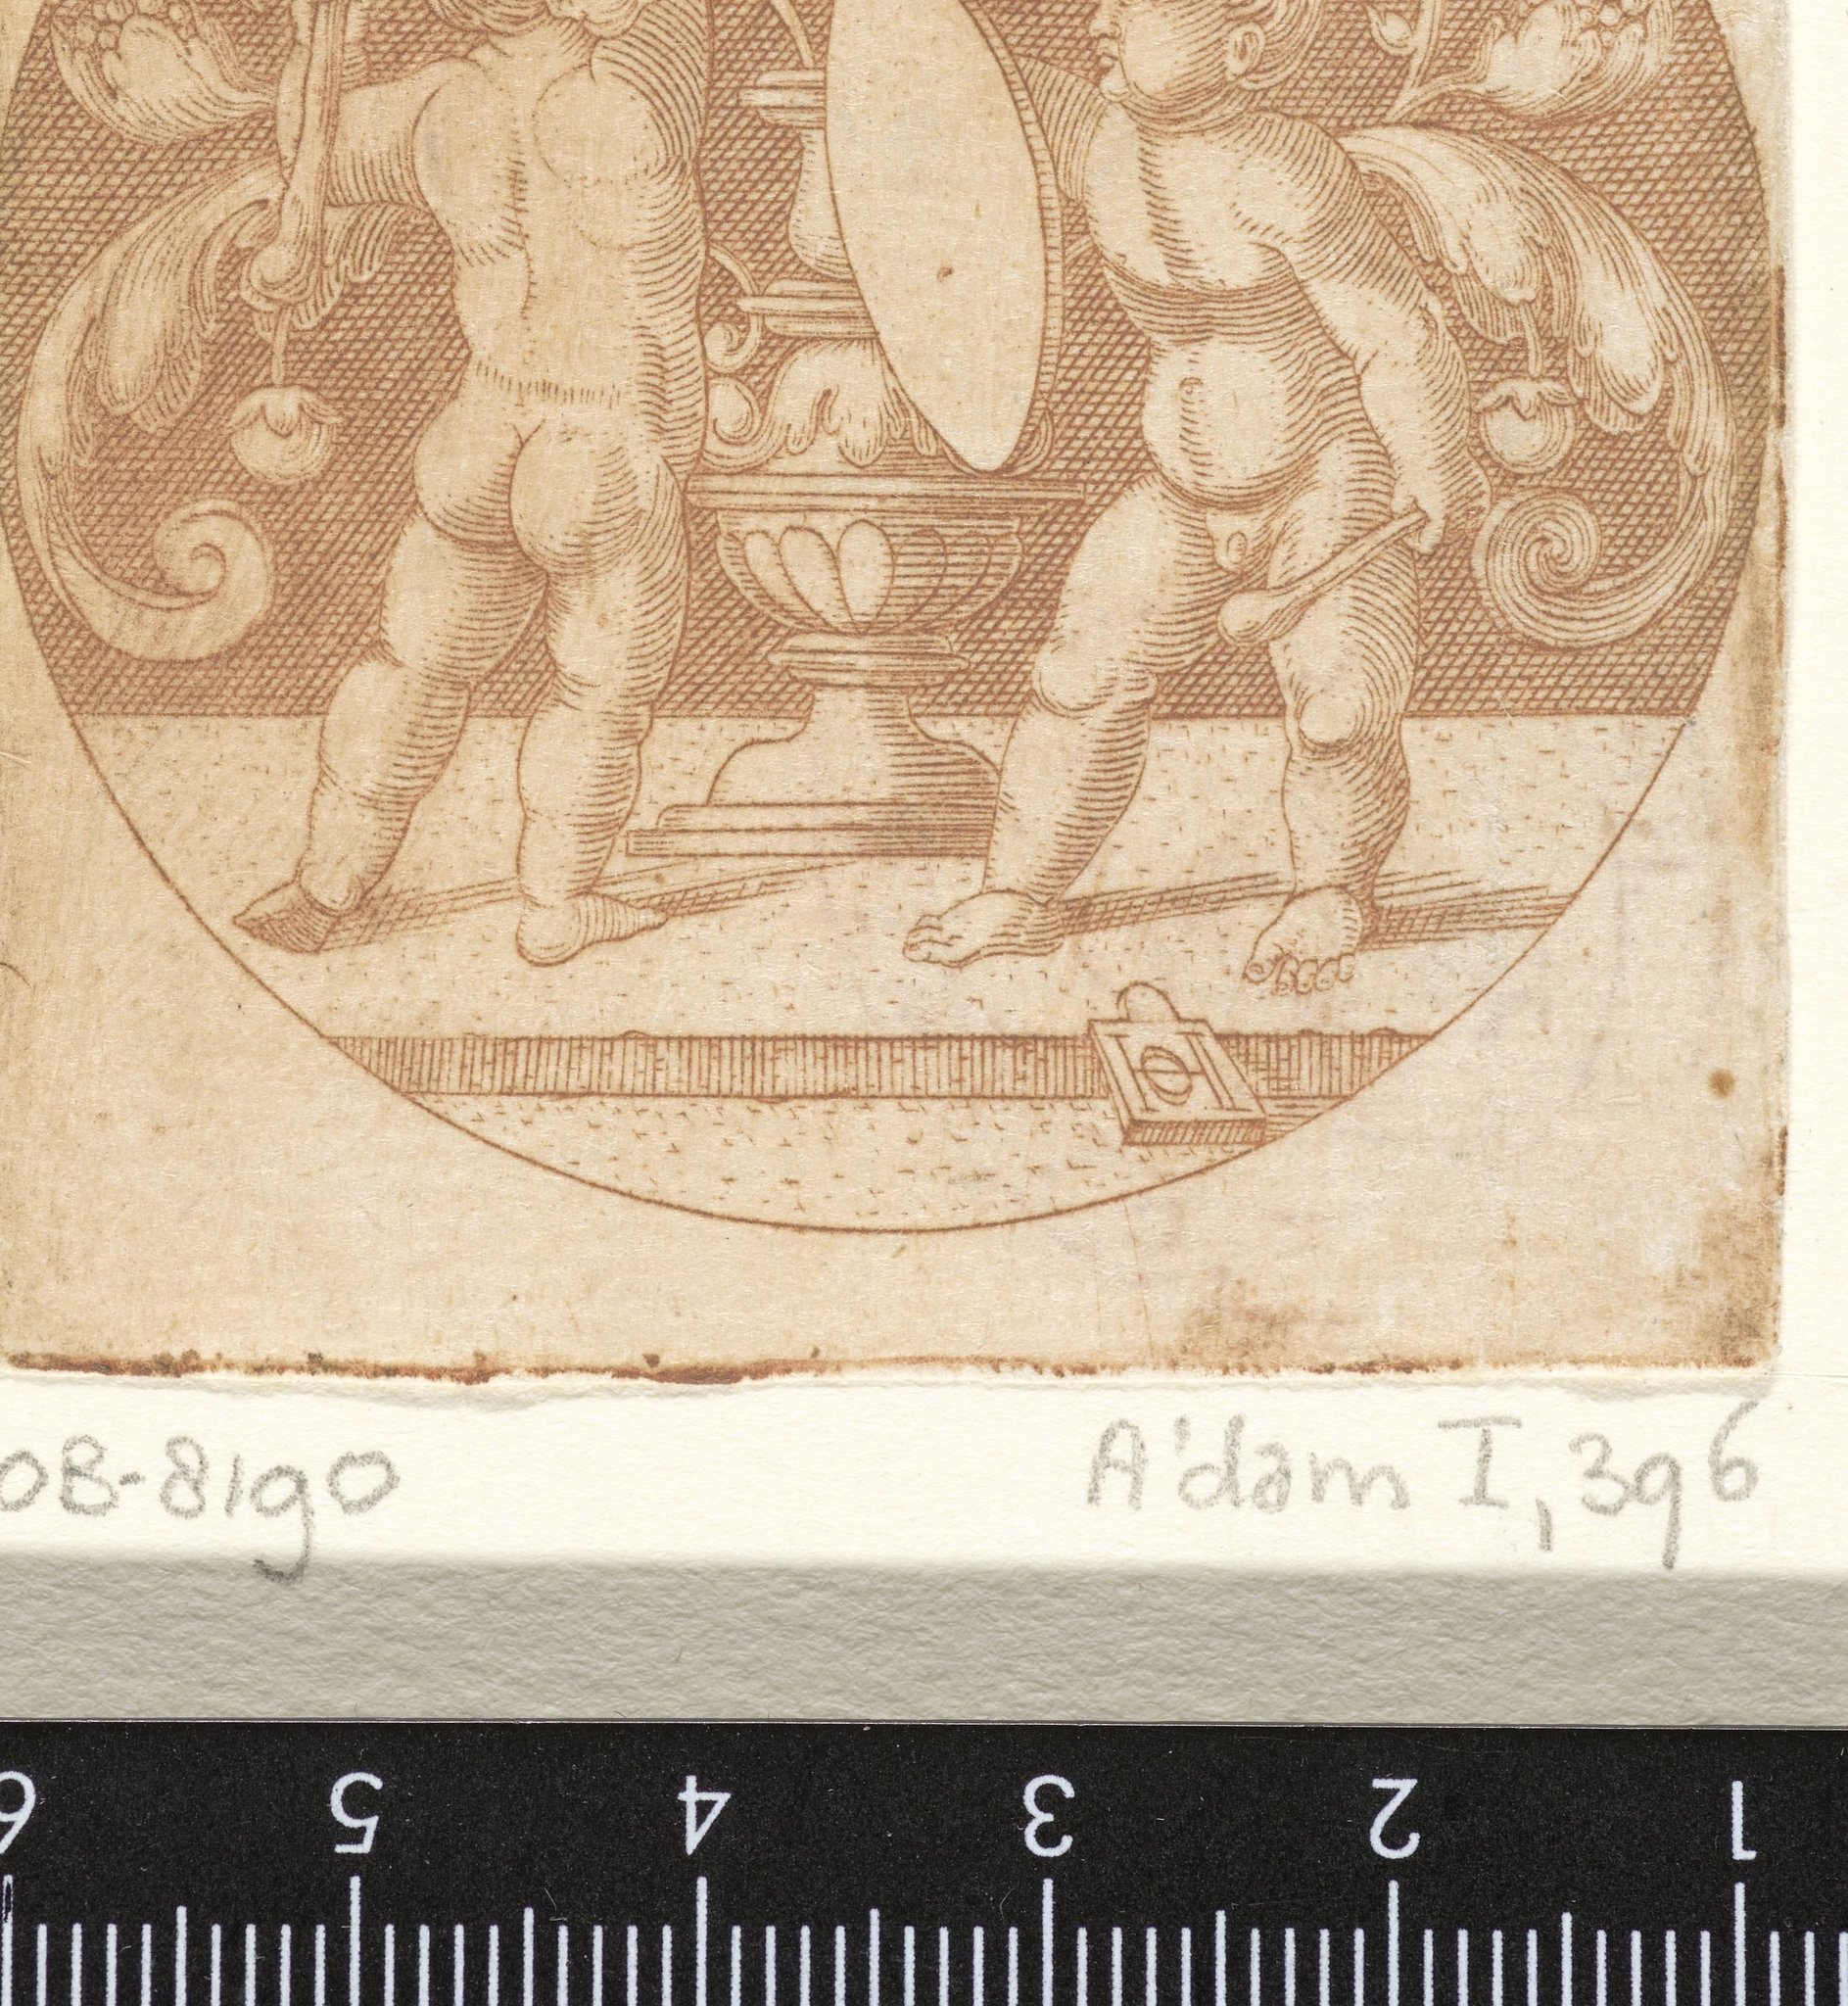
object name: print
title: Medaillon met twee kinderen, gewapend met knotsen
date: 1500-1600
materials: paper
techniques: engraving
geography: germany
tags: protective weapons: shield, cupids: 'amores', 'amoretti', 'putti'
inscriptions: collector's mark: Lugt 240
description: De kinderen staan ter weerszijden van een vaas met bladranken. Gearceerde achtergrond.